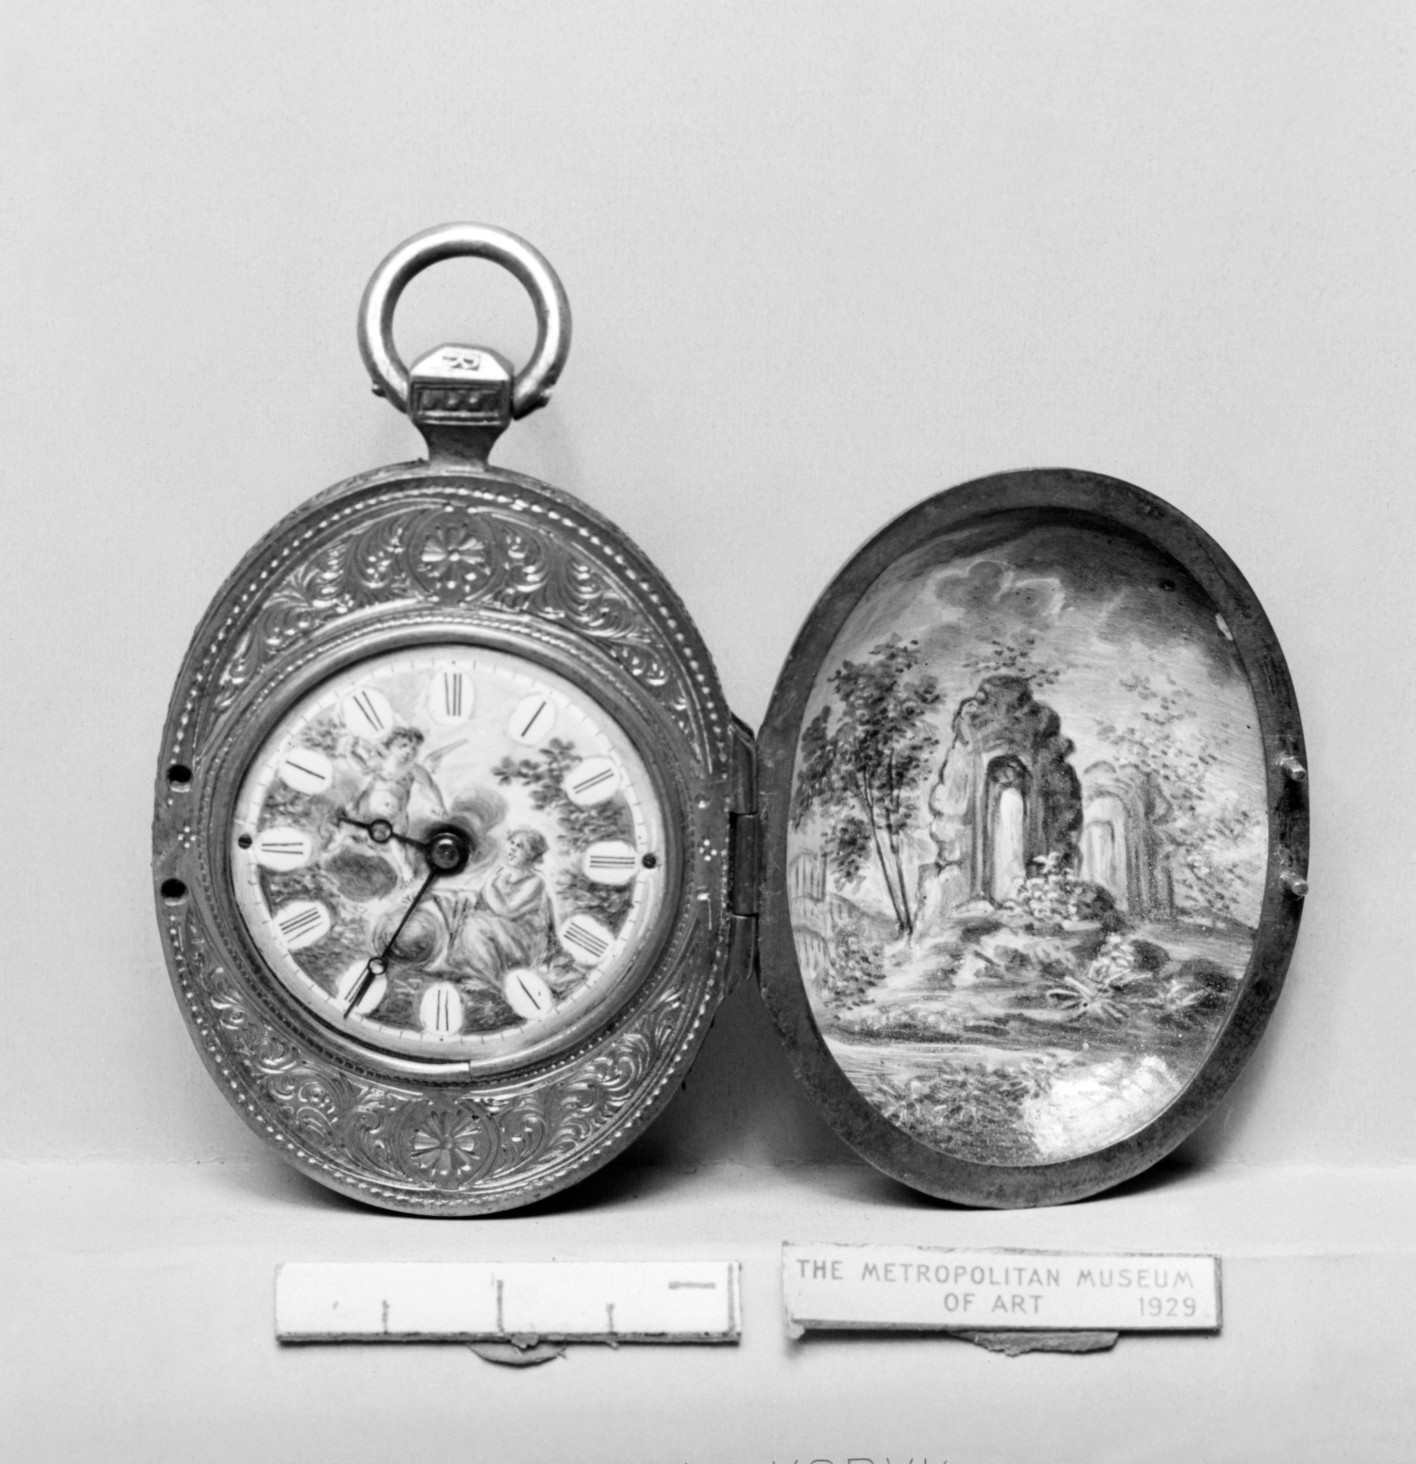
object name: watch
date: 1801-1900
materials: enamel, gilt, metal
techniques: painting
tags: human figures,ruins,flowers,trees